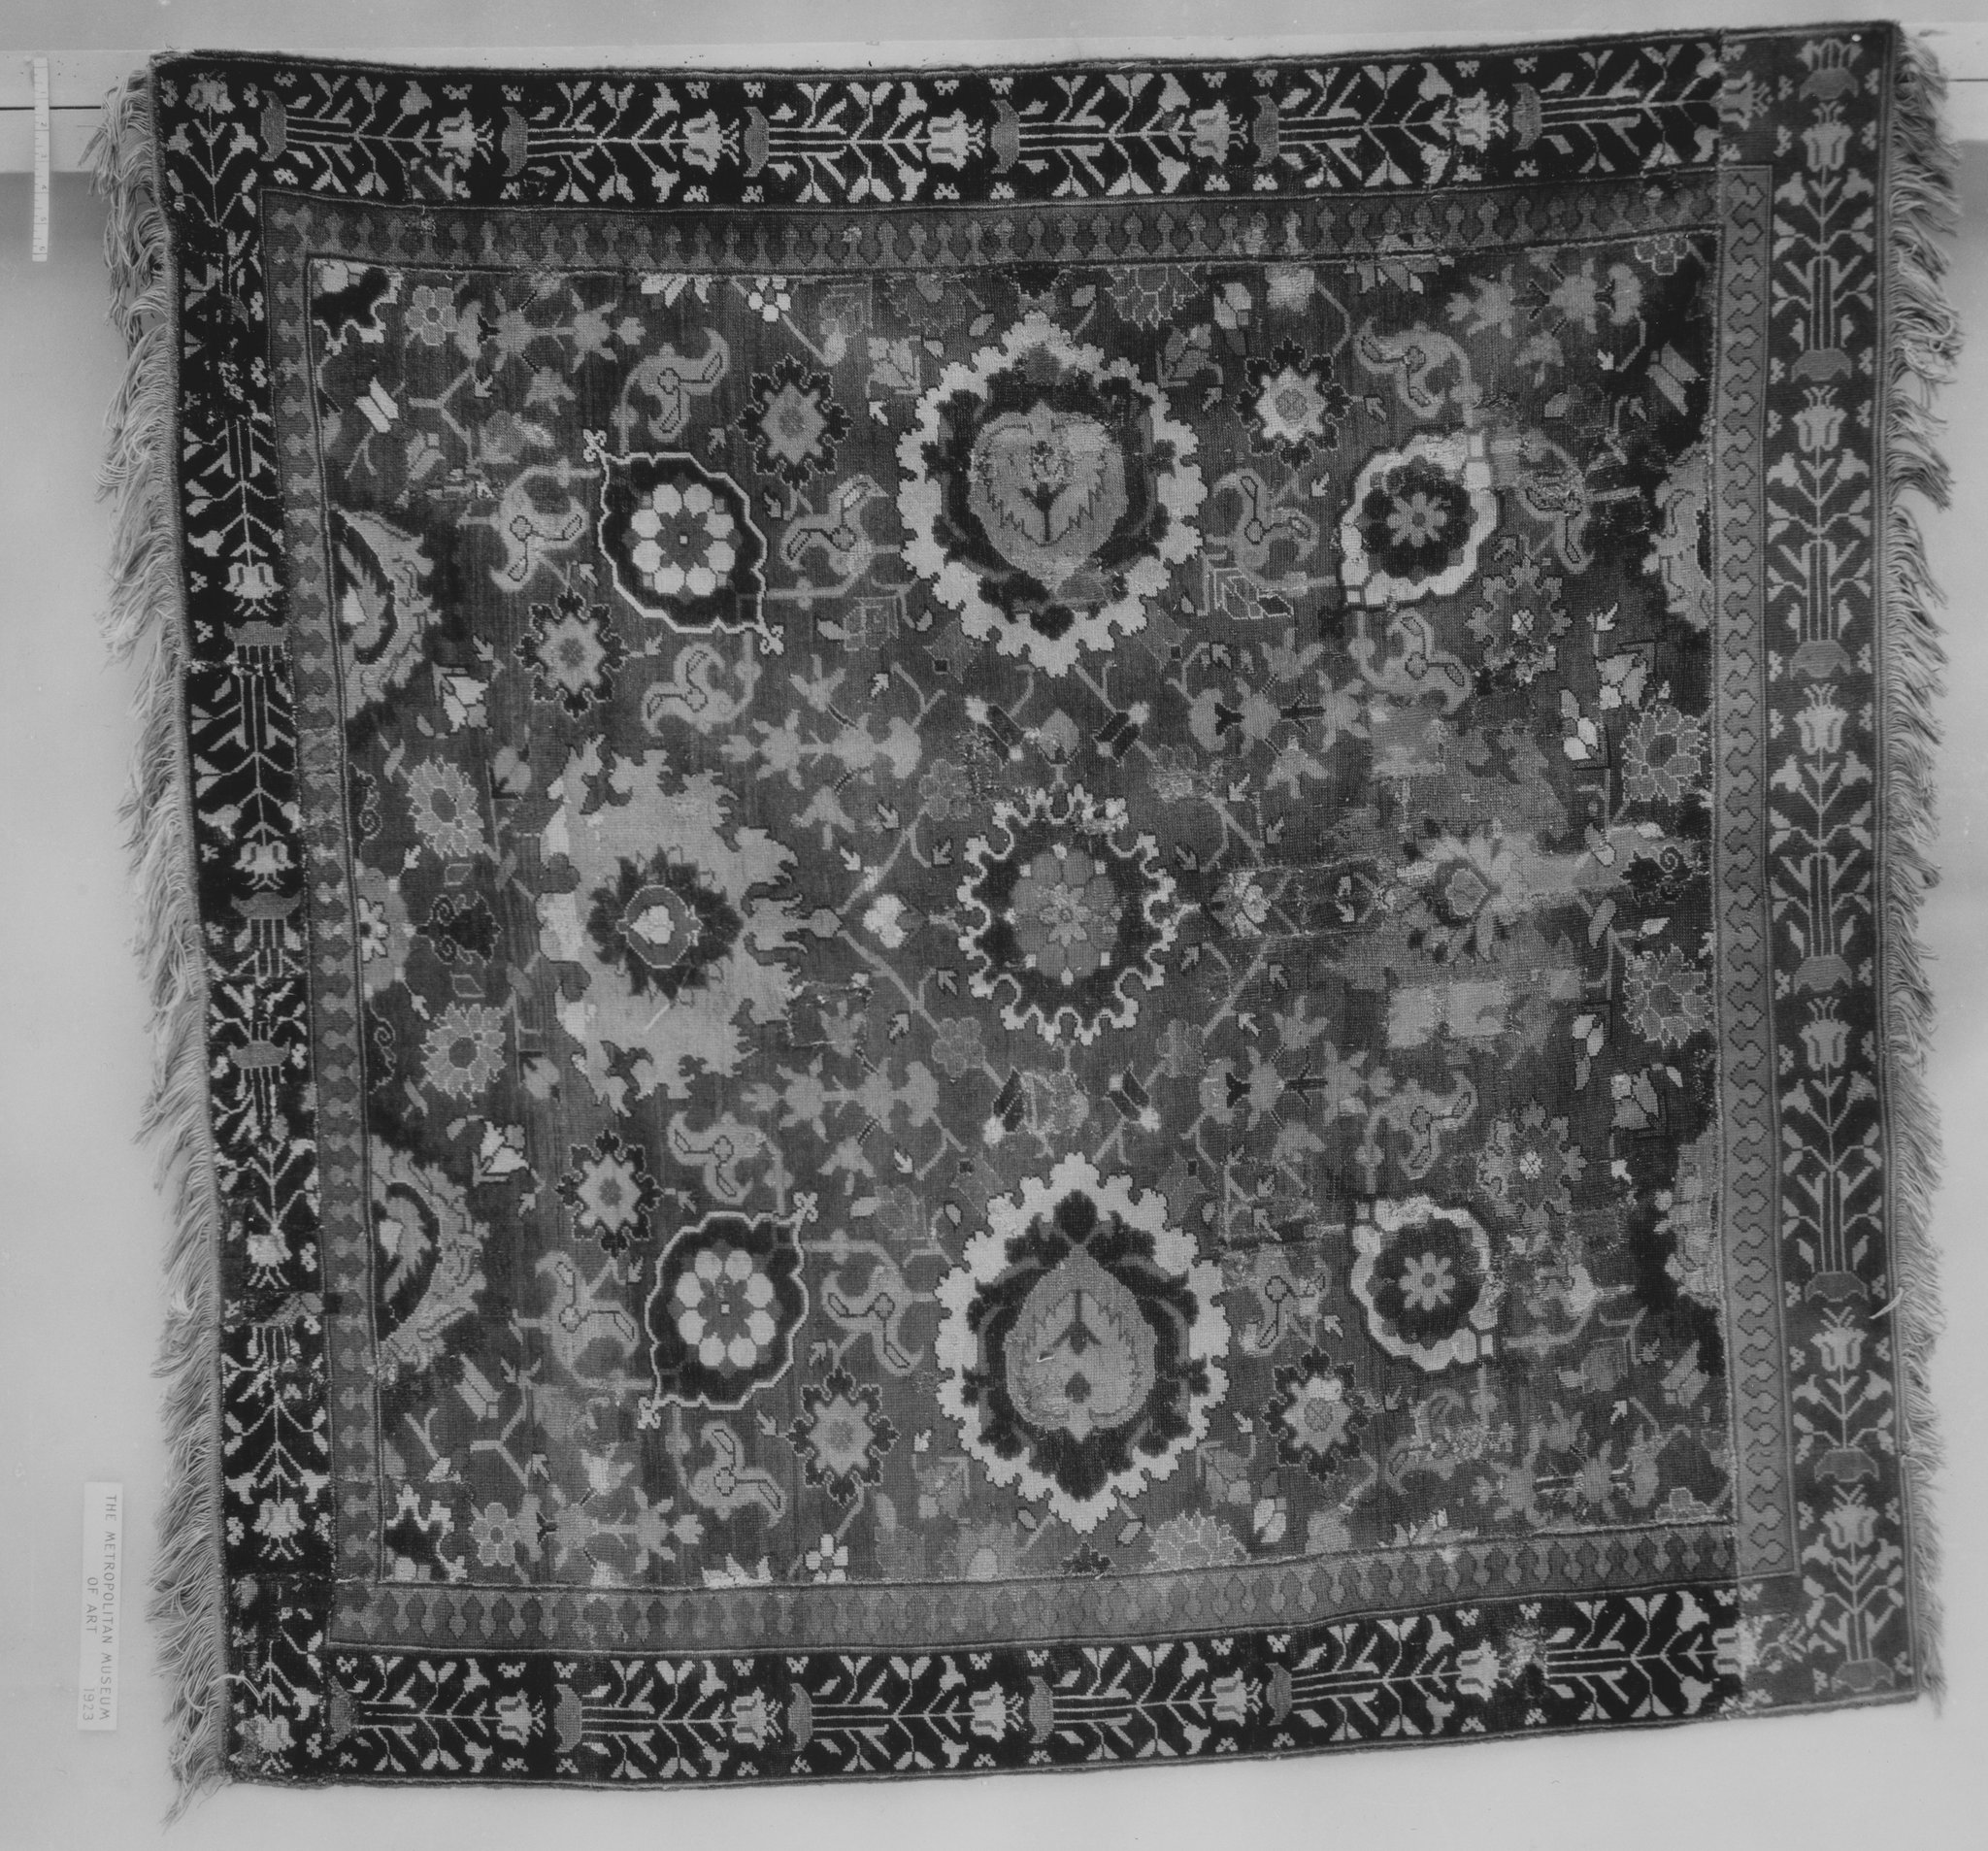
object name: carpet fragment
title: Fragment of a Red-Ground Harshang Carpet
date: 1801-1833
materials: linen, wool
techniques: pile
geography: iran